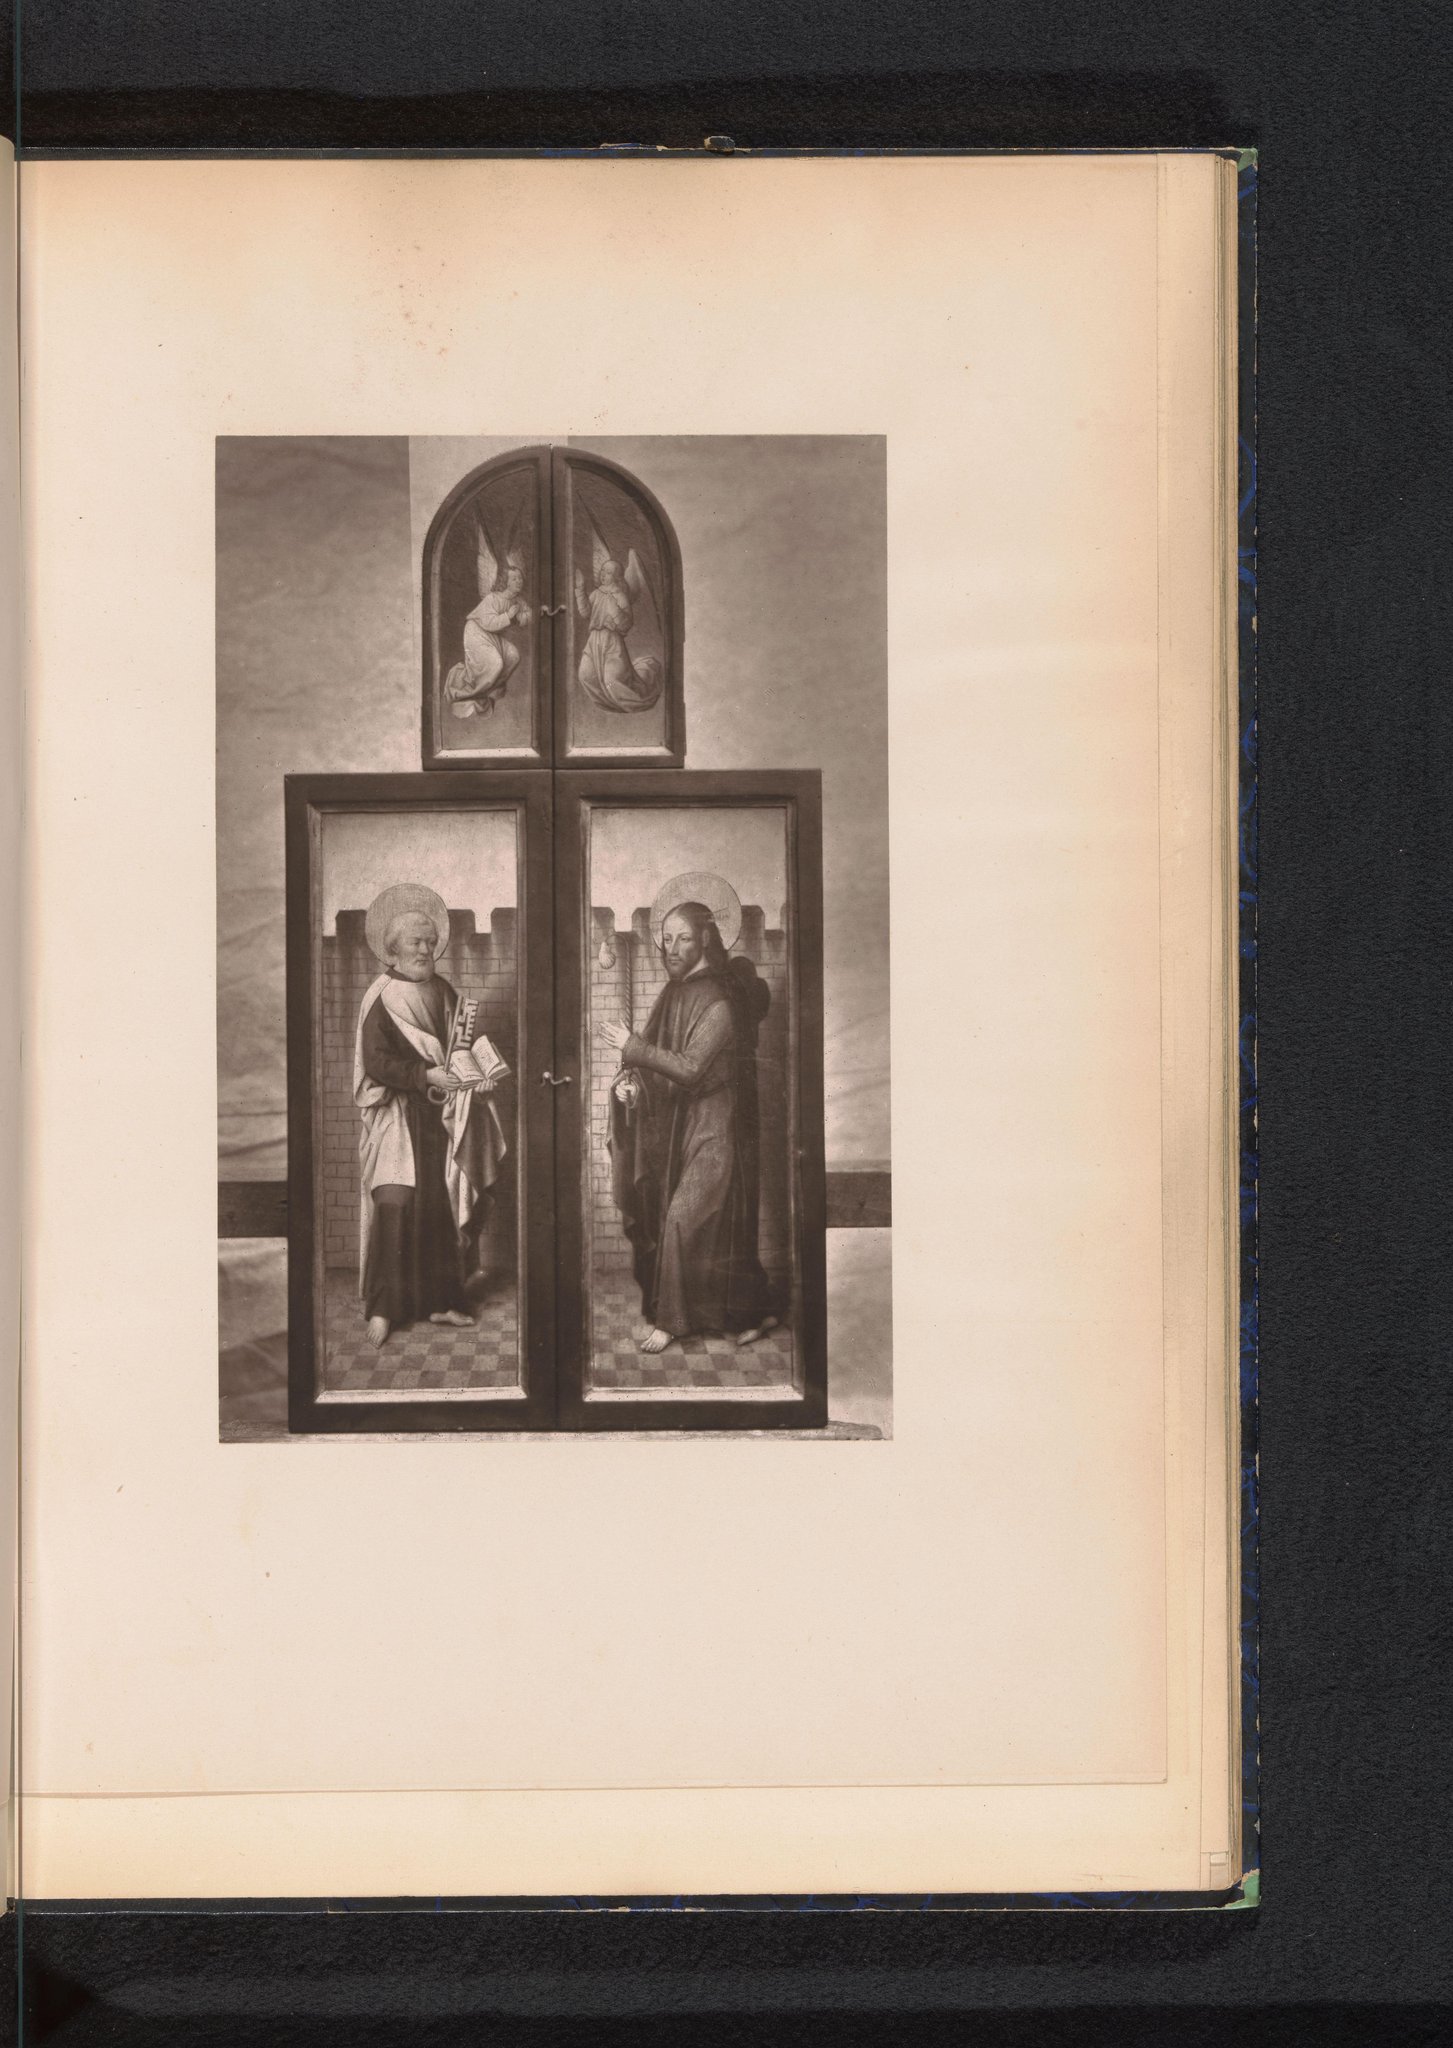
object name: photomechanical print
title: Reproductie van de buitenzijde van een geschilderd triptiek met Bijbelse personen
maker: Anonymous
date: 1878-1883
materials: paper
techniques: woodburytype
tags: angels, the apostle peter, first bishop of rome; possible attributes: book, cock, (upturned) cross, (triple) crozier, fish, key, scroll, ship, tiara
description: Prent op derde ongenummerde pagina na pagina 40.